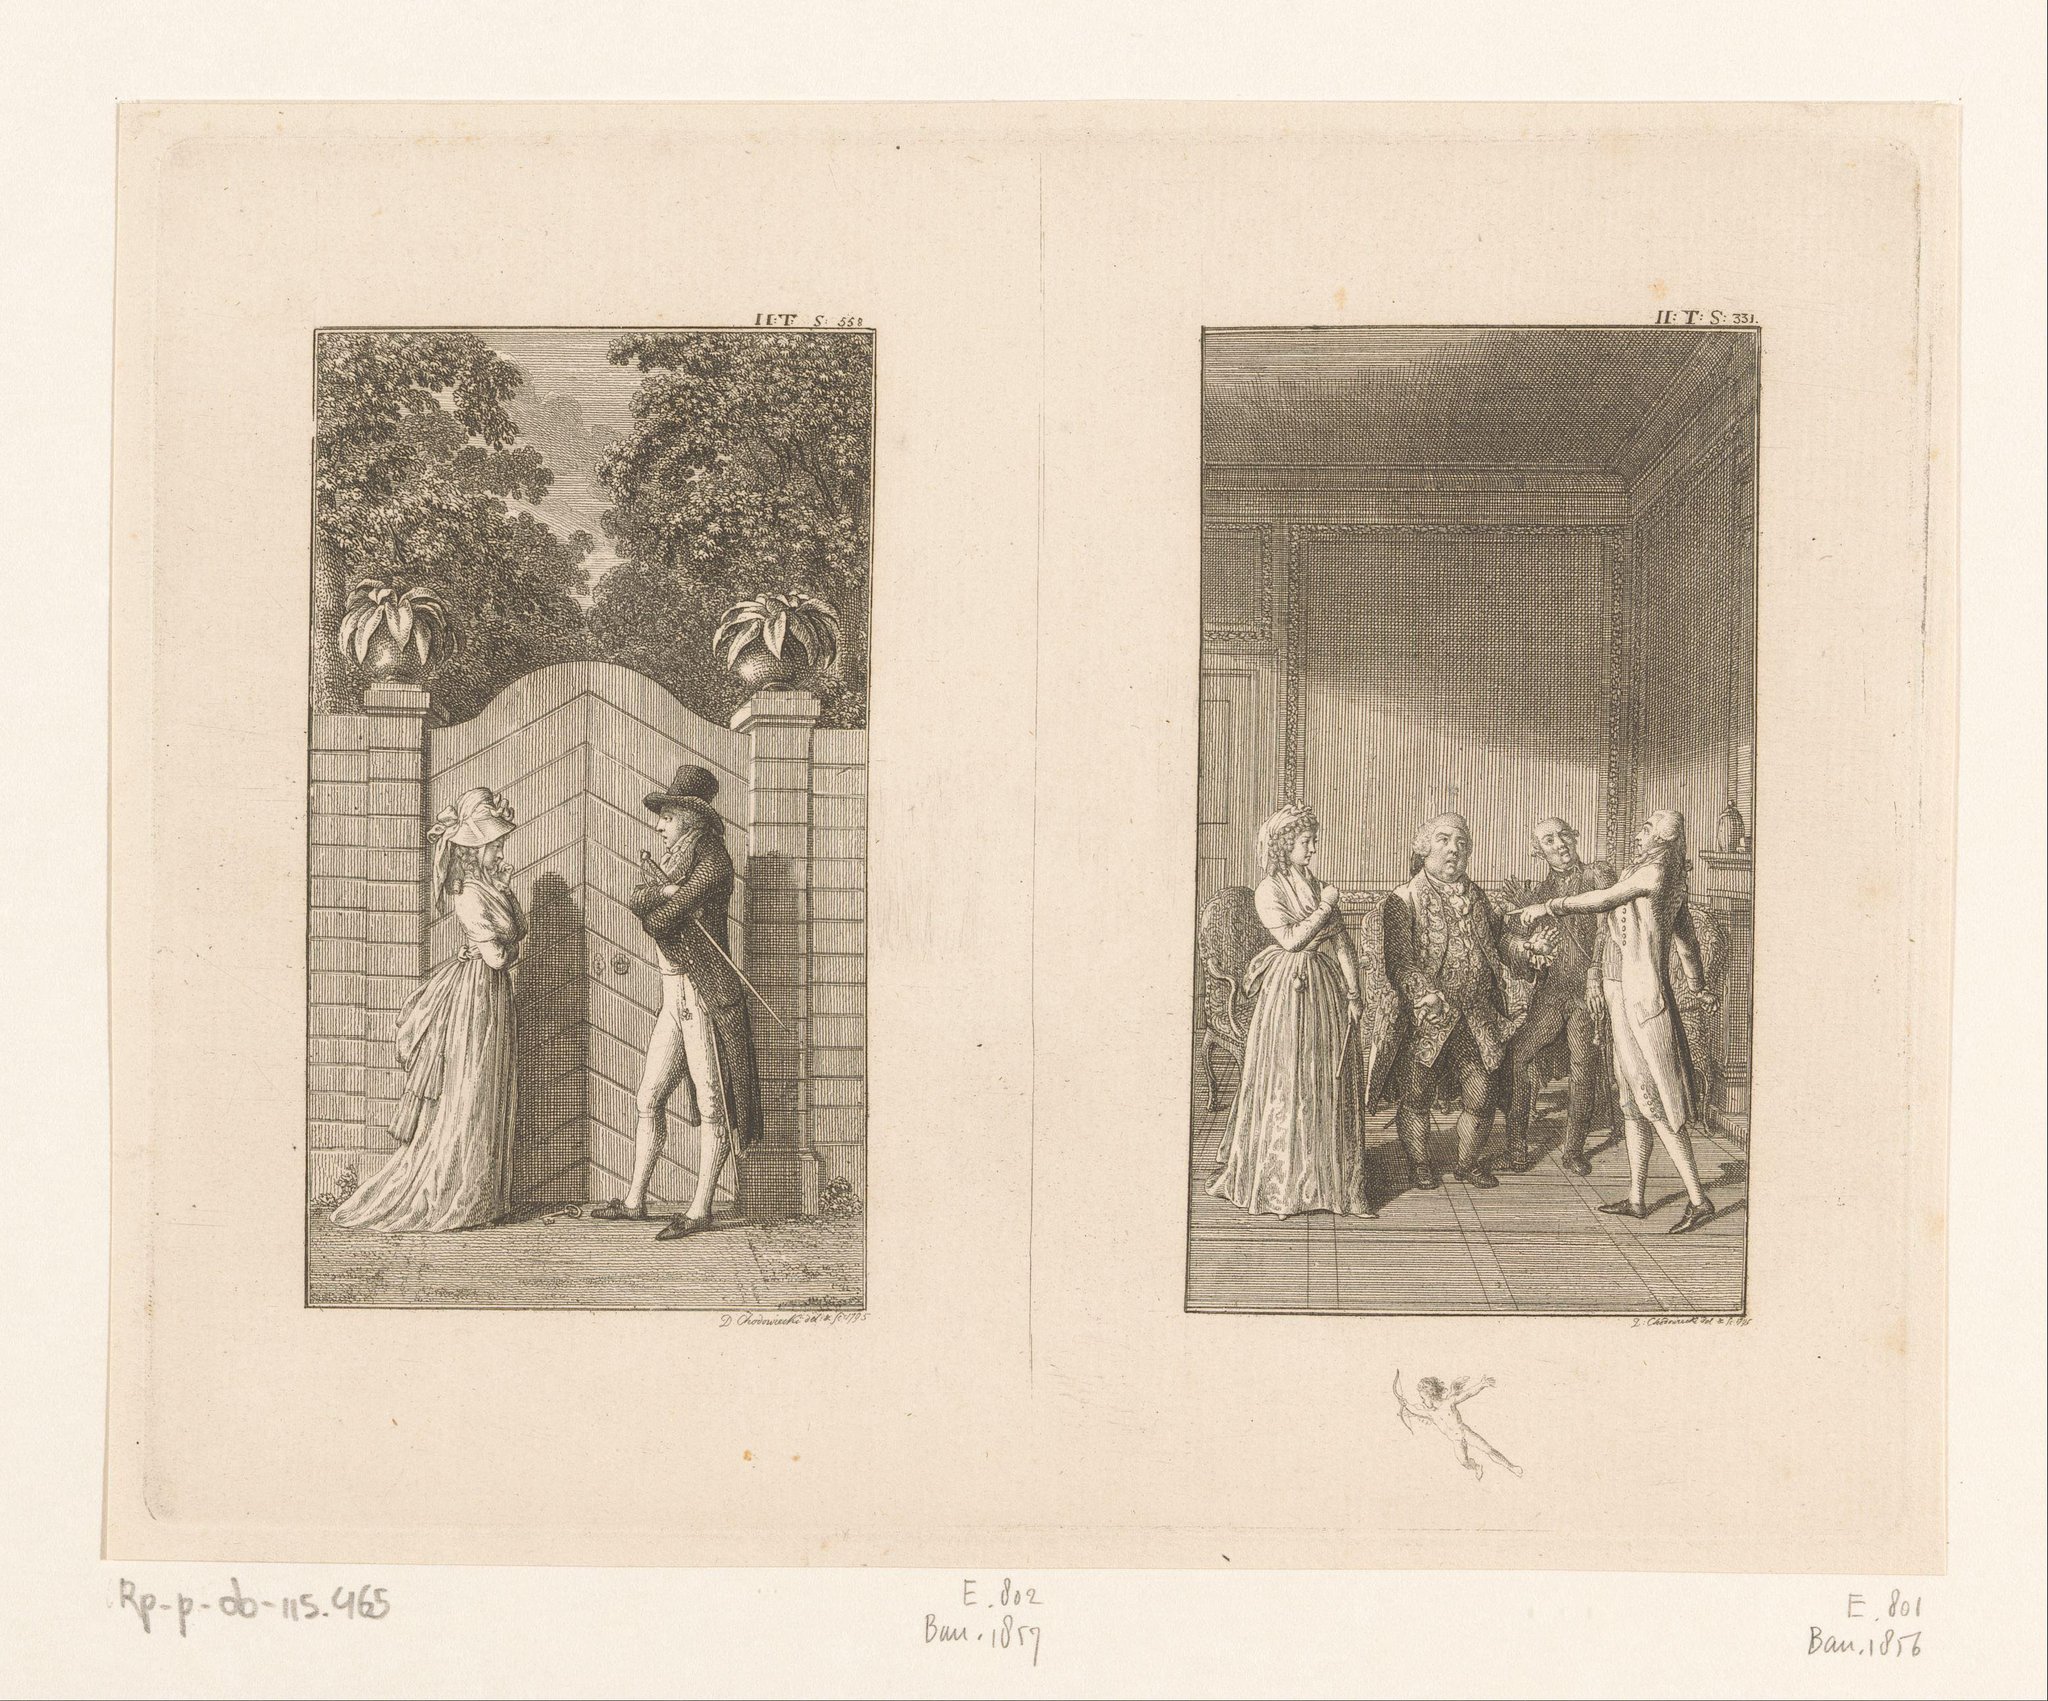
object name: print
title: Twee voorstellingen uit Clarissa van Samuel Richardson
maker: daniel nikolaus chodowiecki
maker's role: draughtsman, print maker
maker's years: 1726-1801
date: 1795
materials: paper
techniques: etching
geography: berlin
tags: literature, key, gate, entrance, index finger forwards, pointing, indicating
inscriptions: collector's mark: Lugt 2228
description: Latere staat gebruikt voor: Richardson, Samuel. Clarissens Schicksale dargestellt in vier und zwanzig Kupferblättern von Daniel Chodowiecki. mit Erläuterungen des Deutschen Uebersetzers Dr. L. Th. Kosegarten. Leipzig: Heinrich Gräff, 1796.